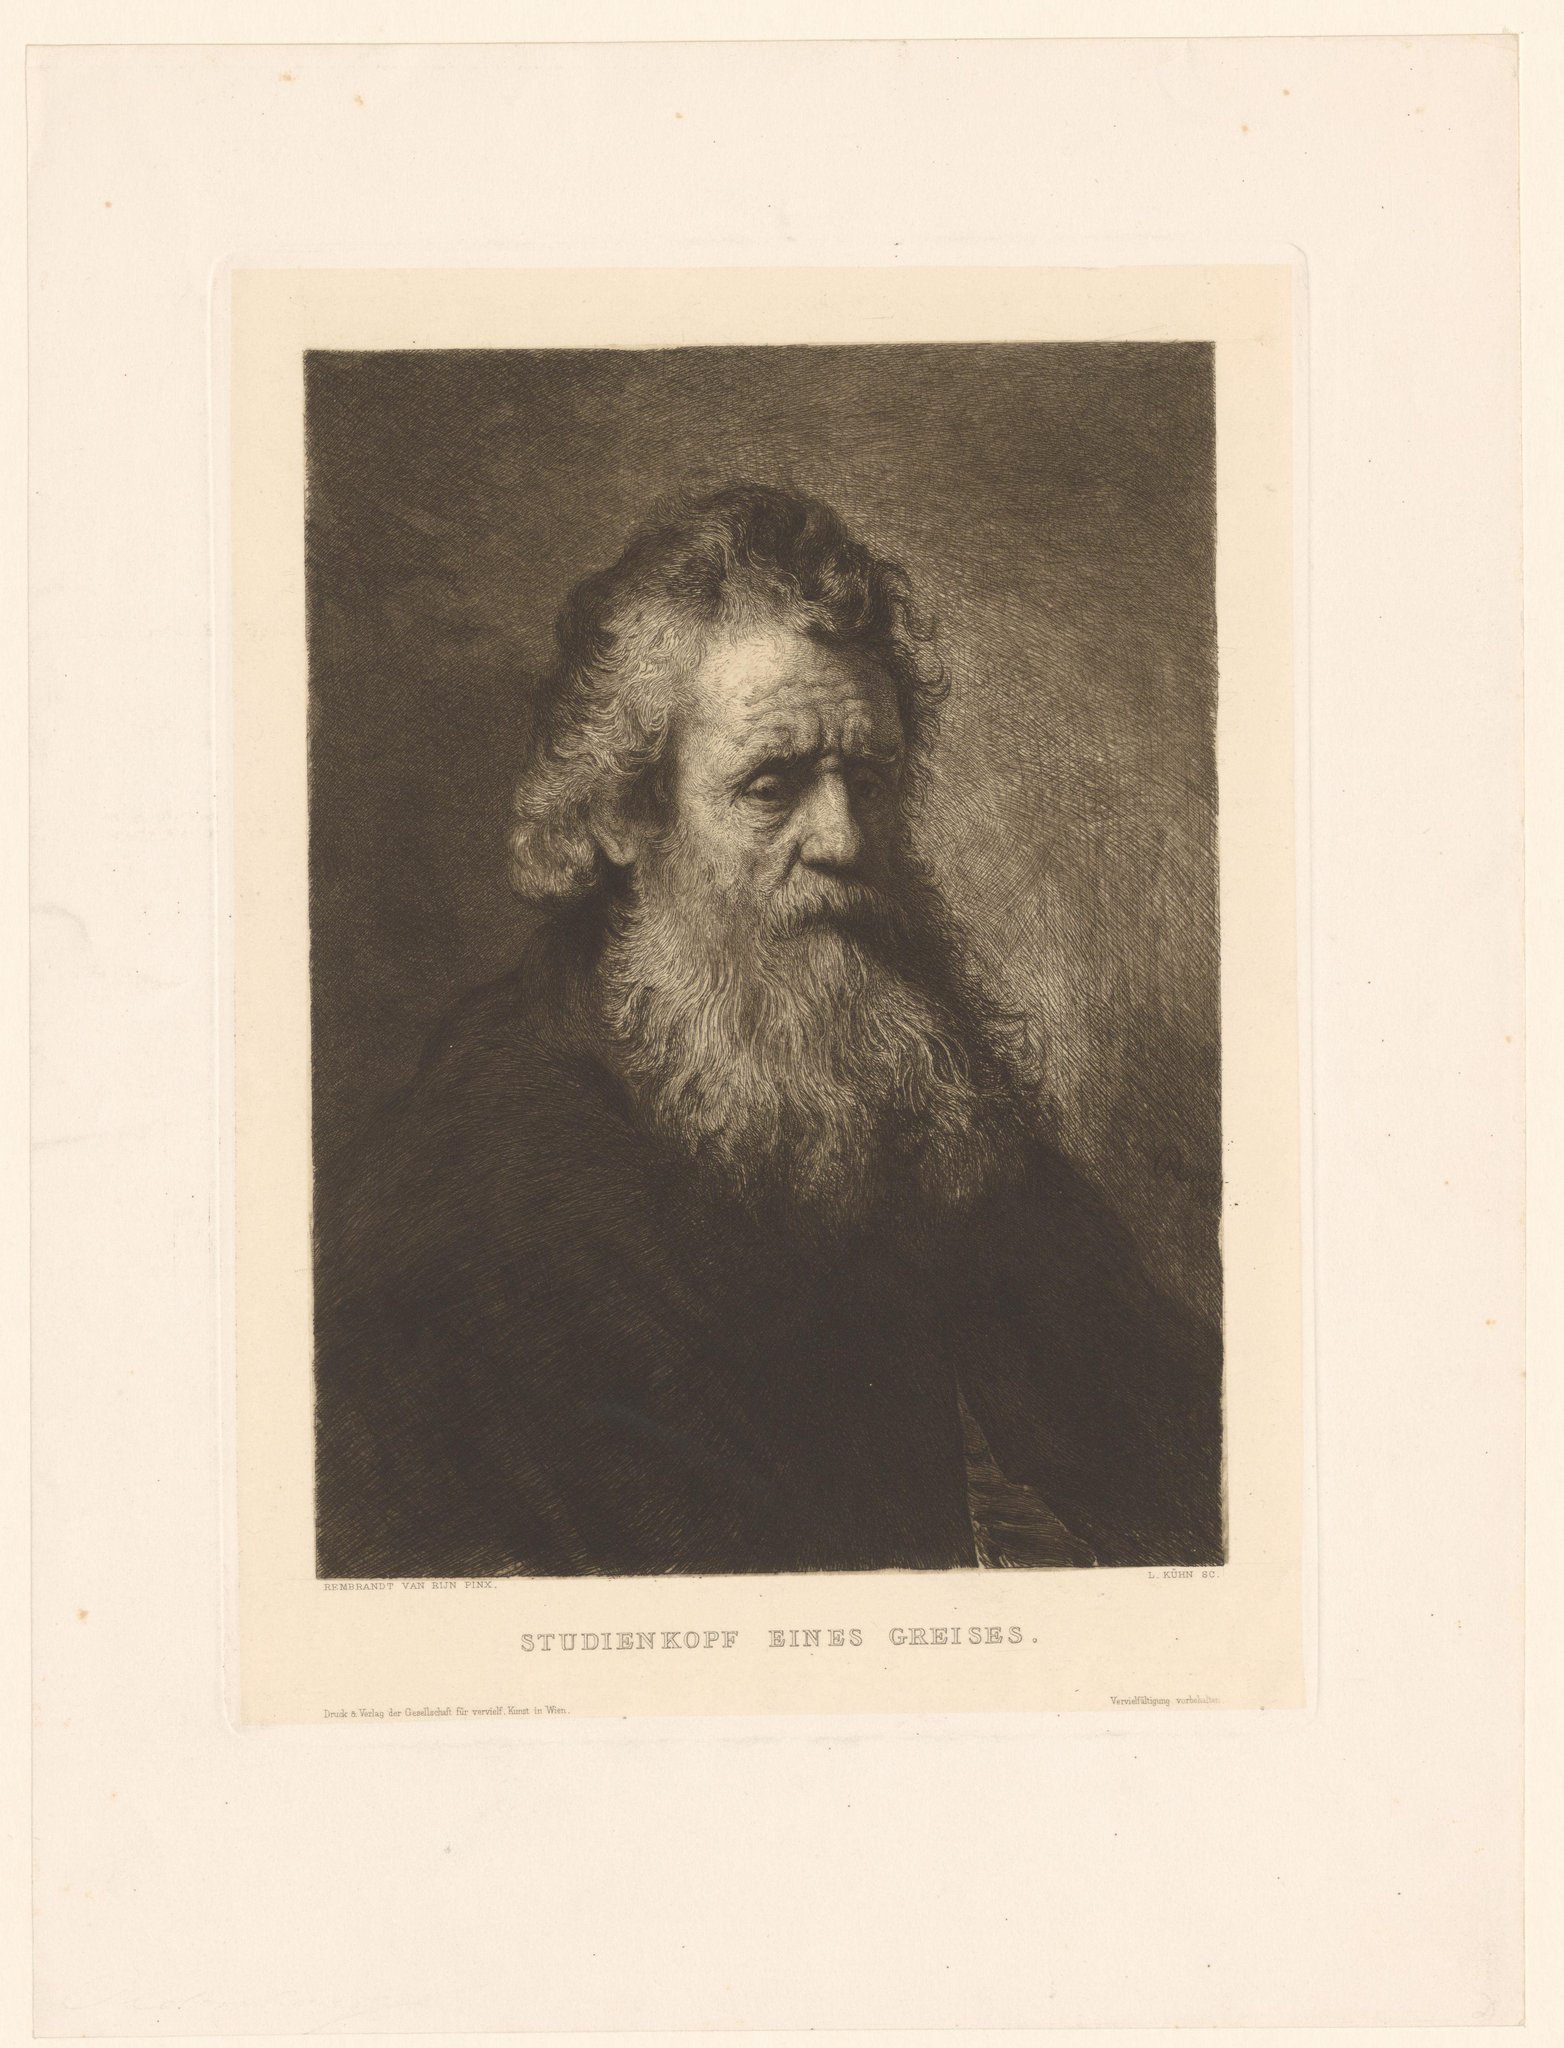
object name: print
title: Studienkopf eines Greises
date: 1871-1934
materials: paper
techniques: etching, intaglio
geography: vienna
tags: anonymous historical person portrayed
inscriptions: collector's mark: Lugt 2228, signature: ‘R’, date: ‘Jan 1630’, collector's mark: Lugt 2228